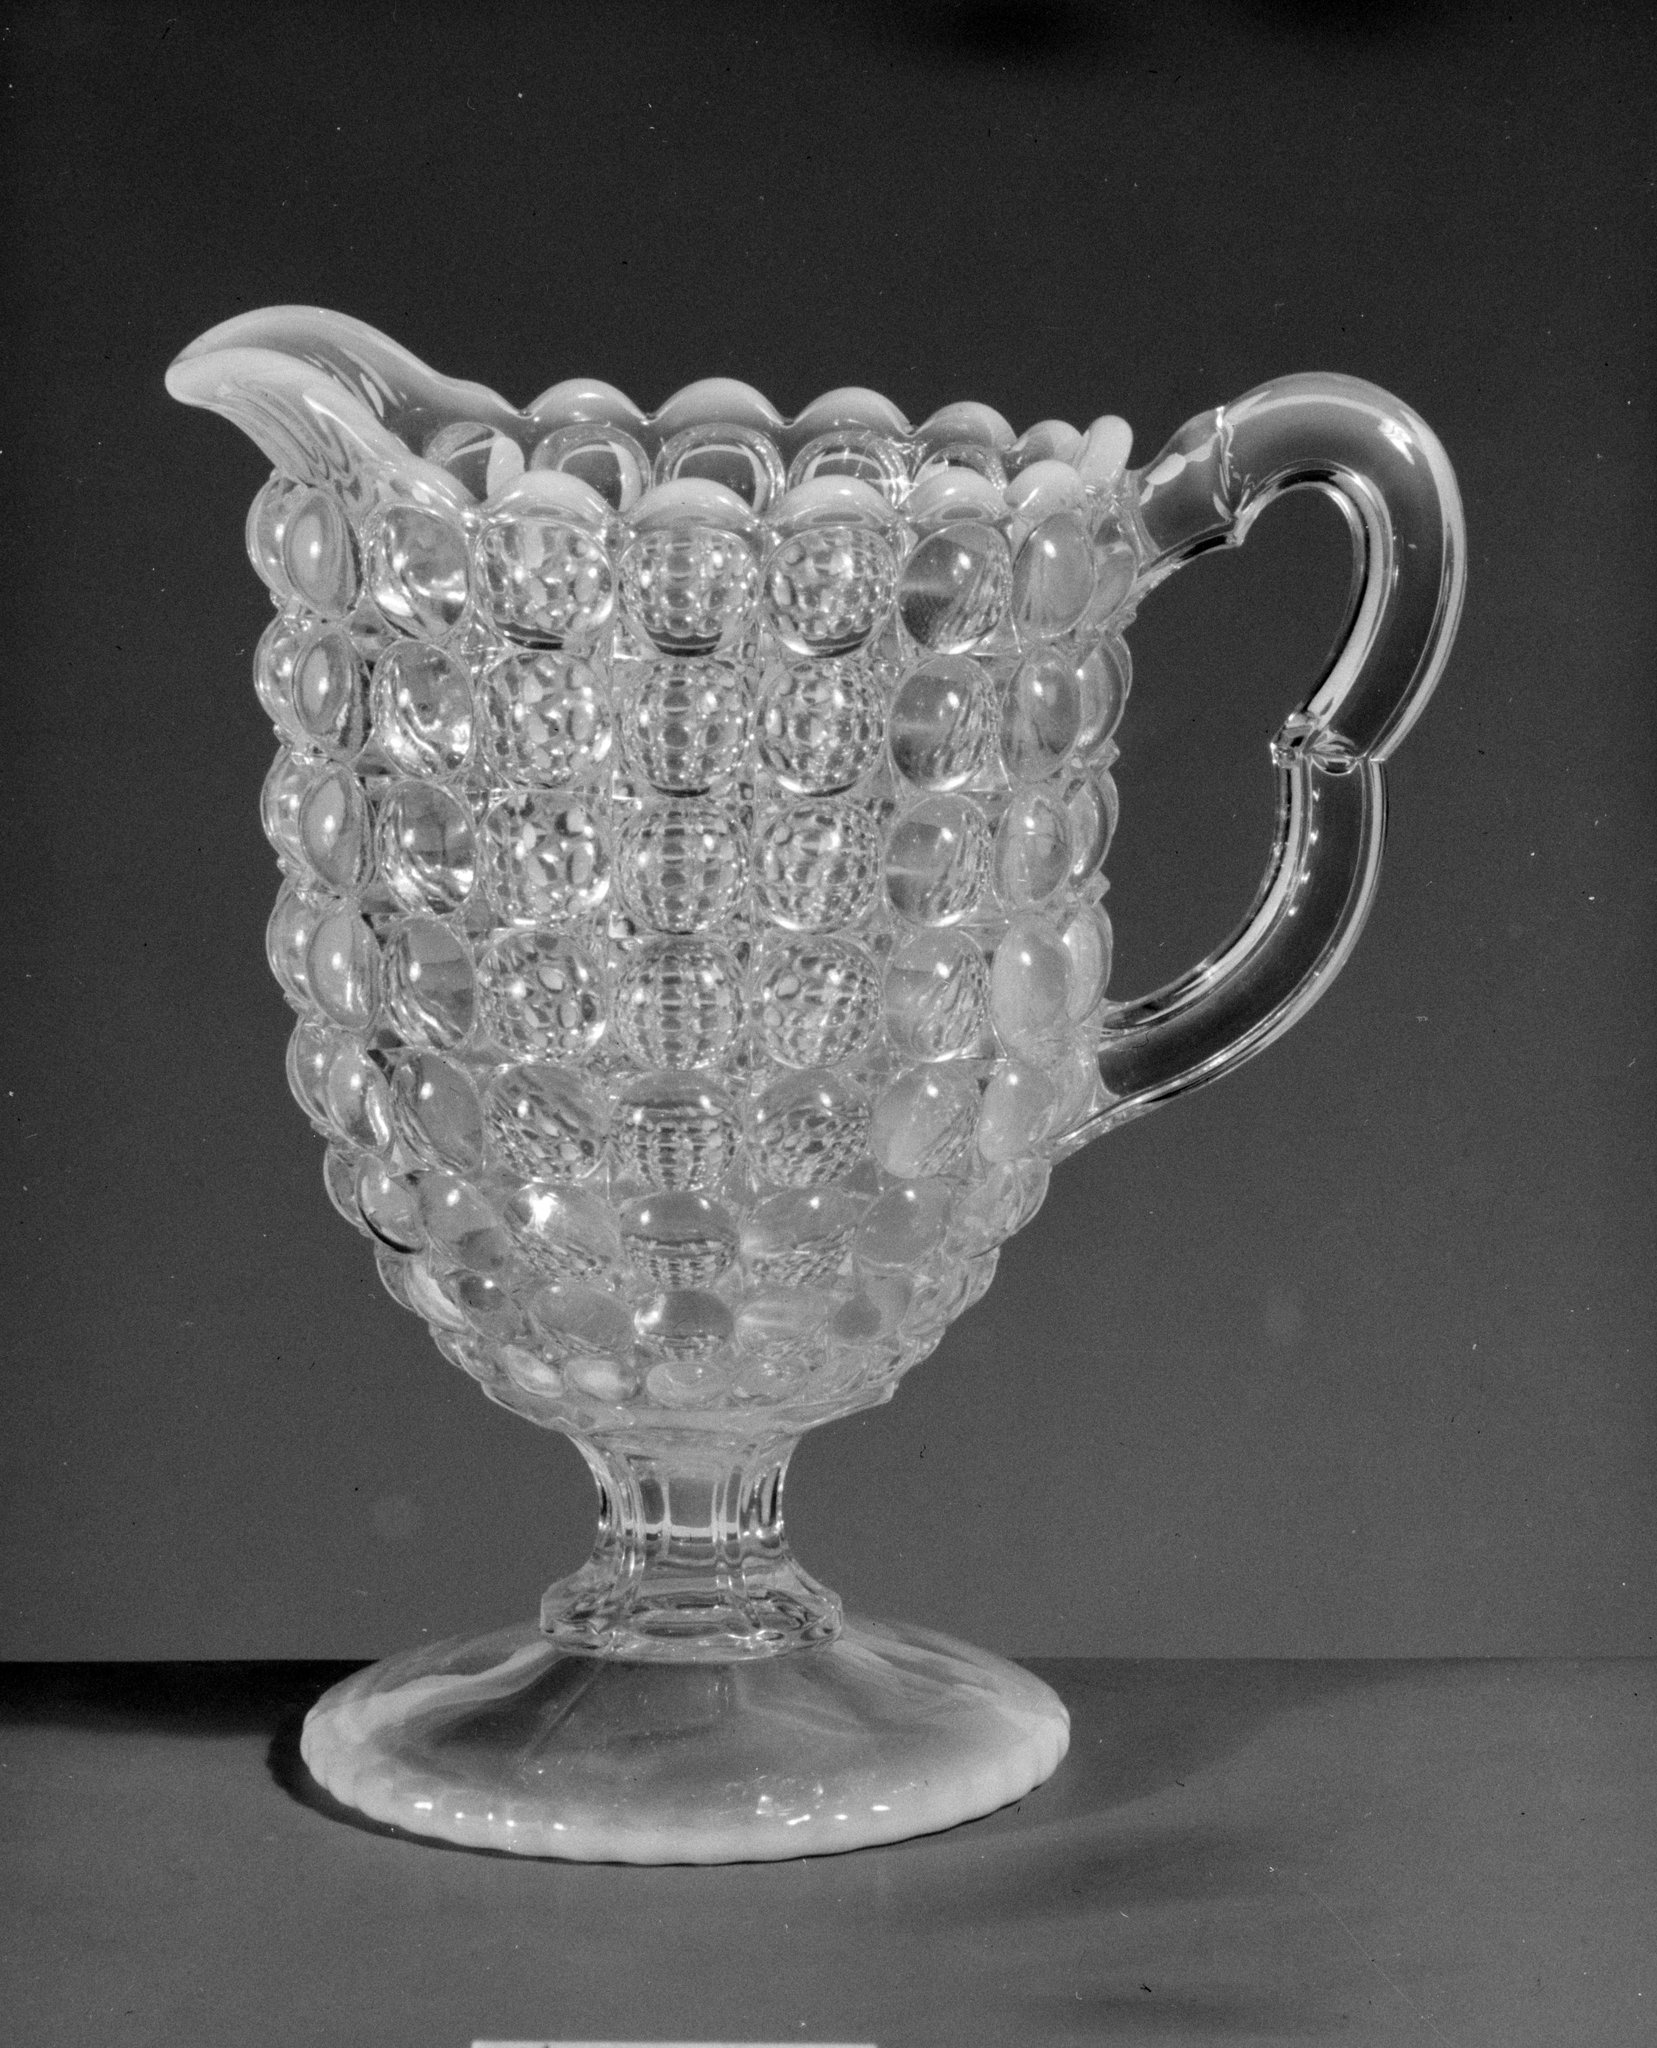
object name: cream pot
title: Creamer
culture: american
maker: richards and hartley flint glass co.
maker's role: maker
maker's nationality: american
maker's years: 1867-1890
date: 1888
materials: glass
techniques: pressed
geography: united states